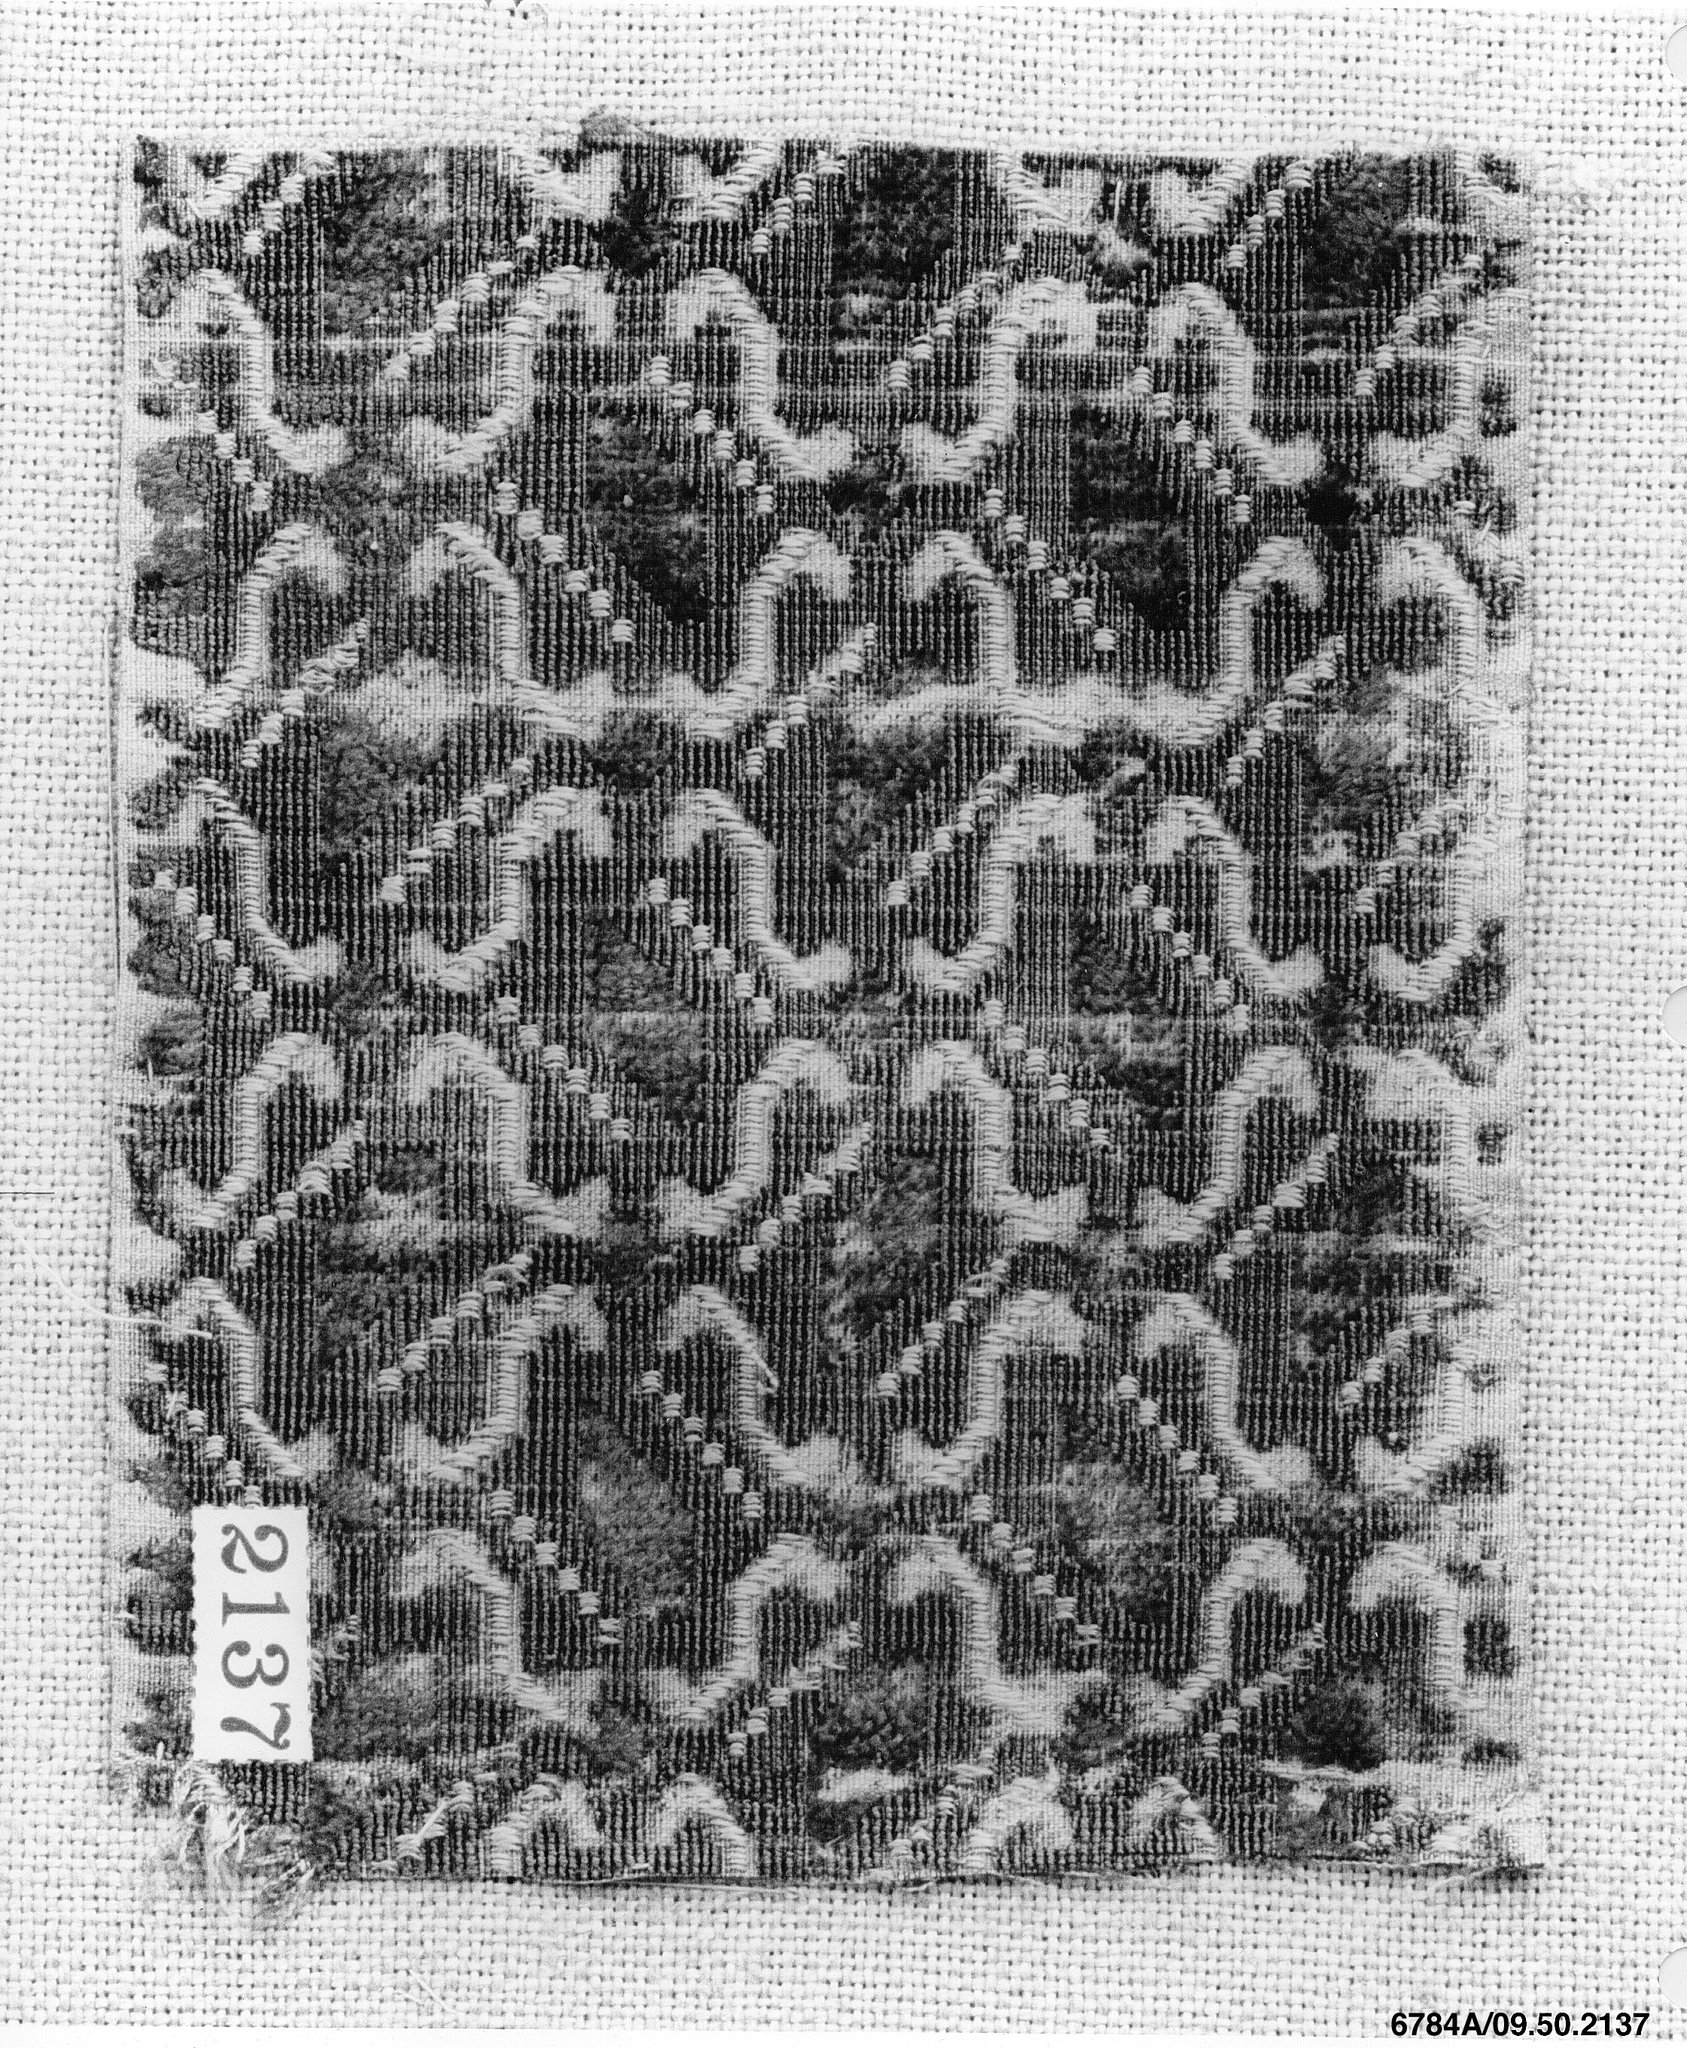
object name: piece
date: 1501-1700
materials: silk